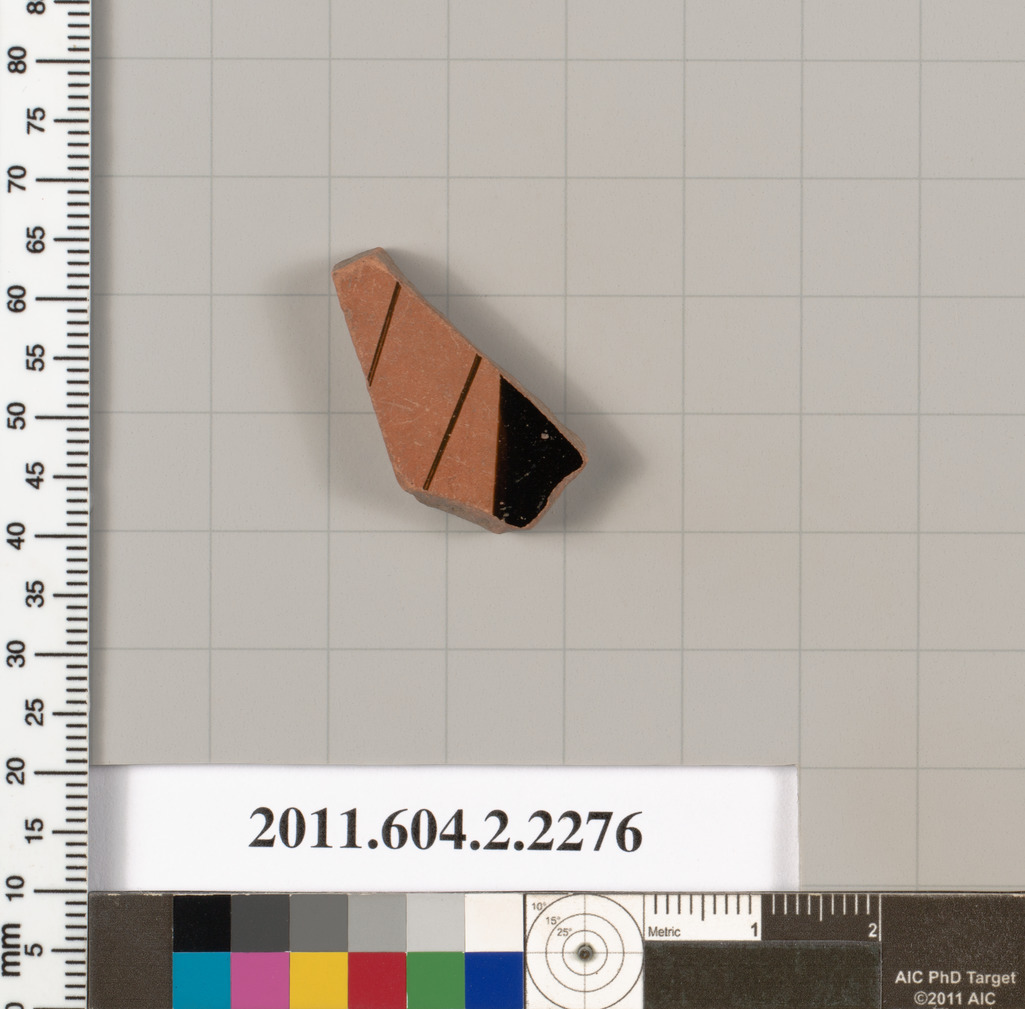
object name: pot fragment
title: Terracotta fragment of a pot; glazed on the inside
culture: greek, attic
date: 475-451 BCE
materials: terracotta